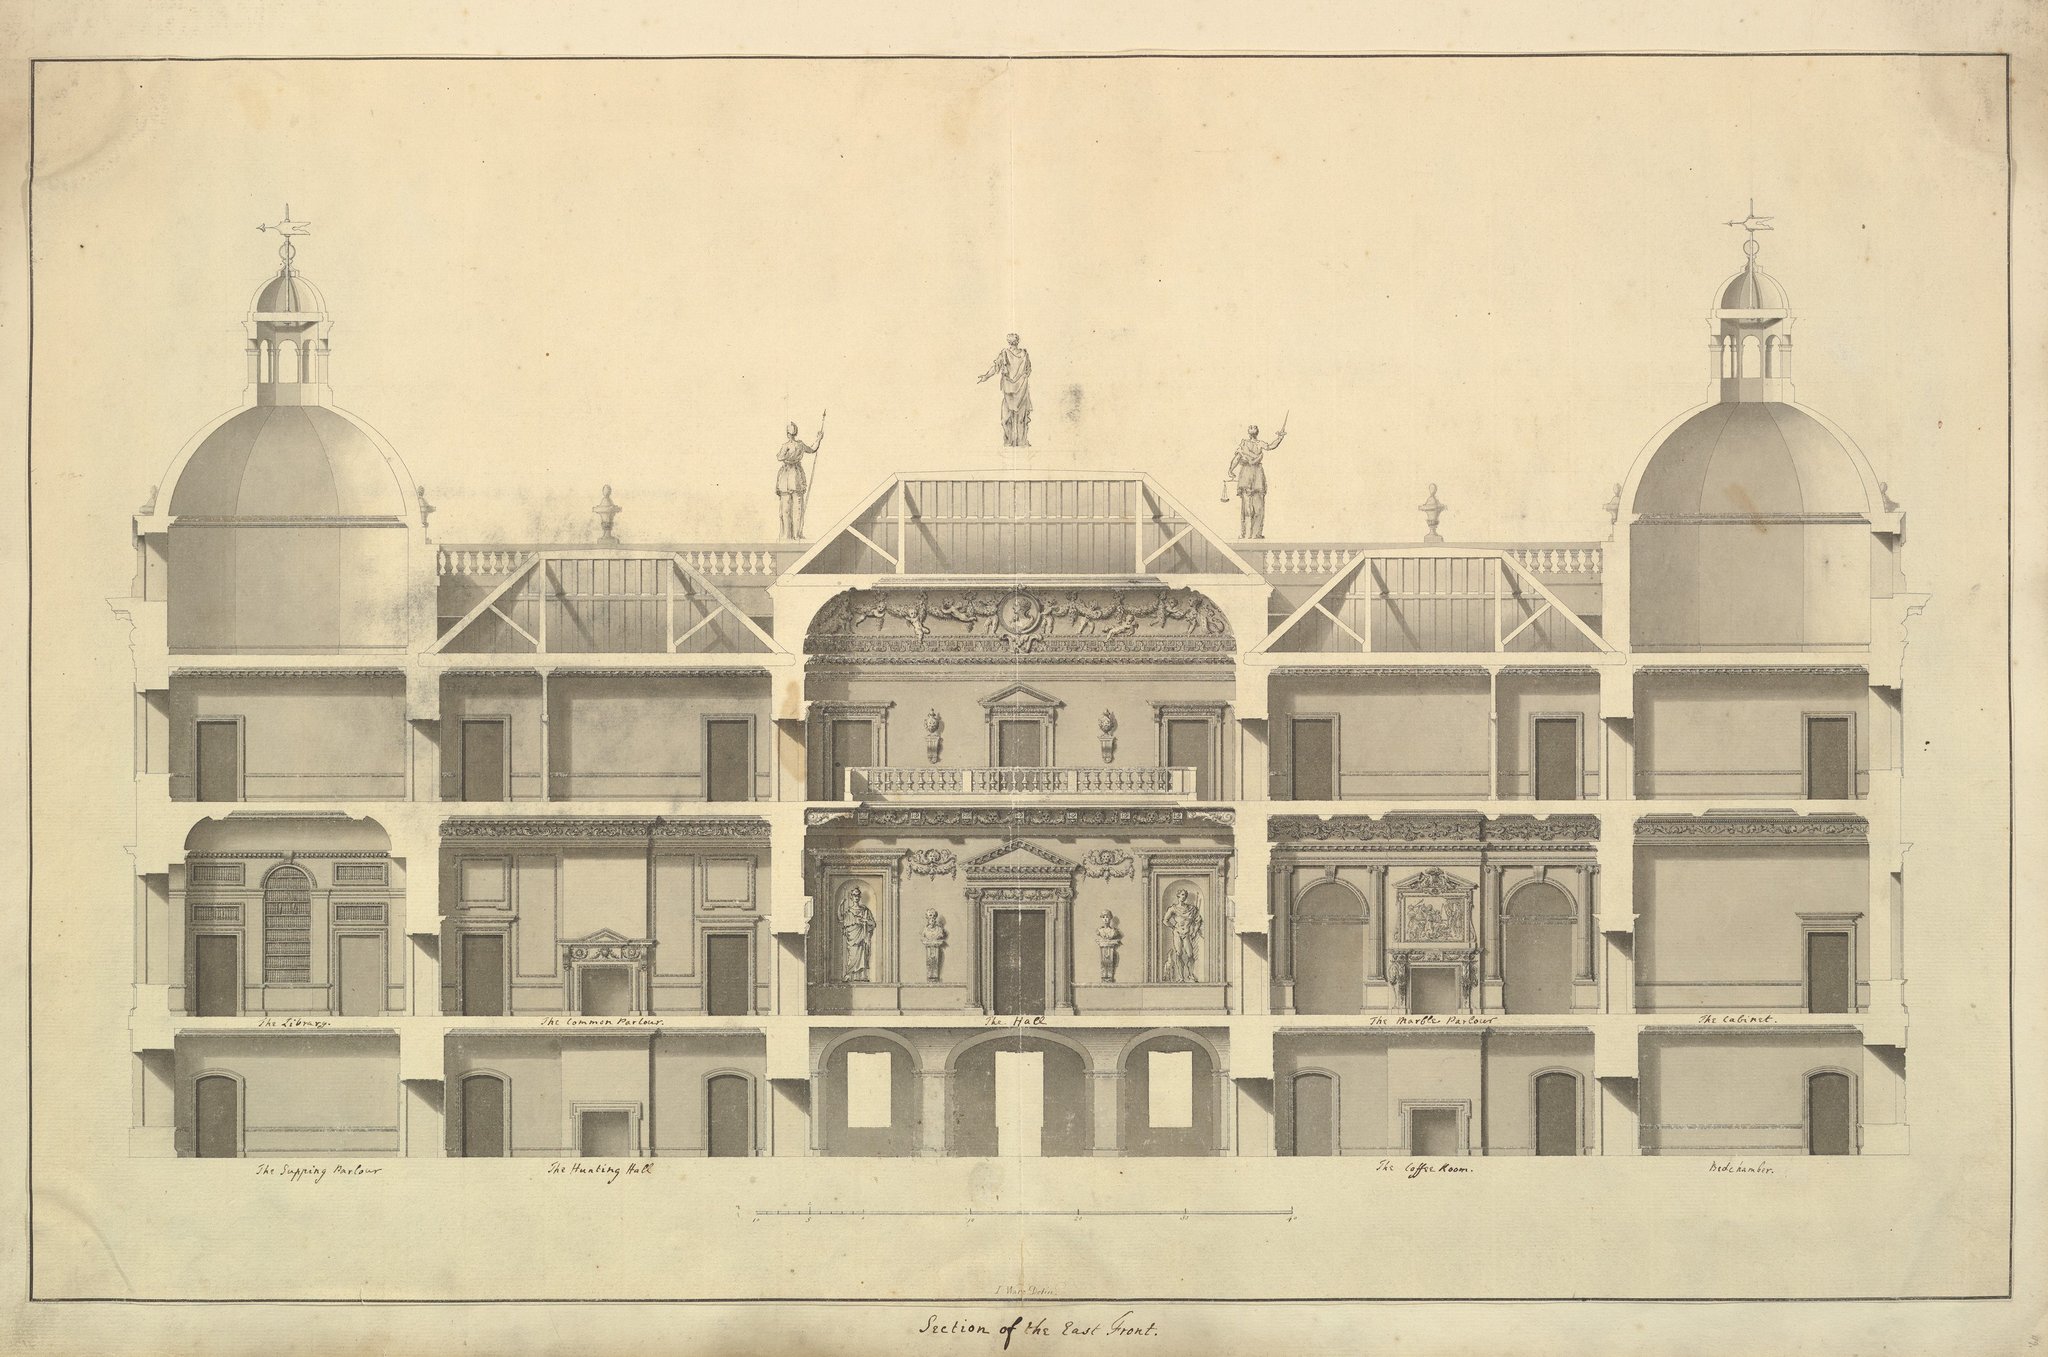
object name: drawing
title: Section of the East Front, Houghton Hall, Norfolk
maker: isaac ware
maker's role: artist and architect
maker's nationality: british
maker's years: 1704-1766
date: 1735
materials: ink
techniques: brush, pen, wash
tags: architecture,buildings,houses